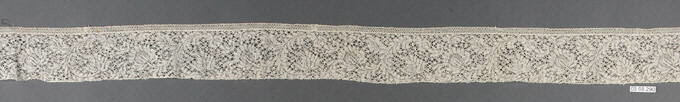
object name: strip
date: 1601-1700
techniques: lace